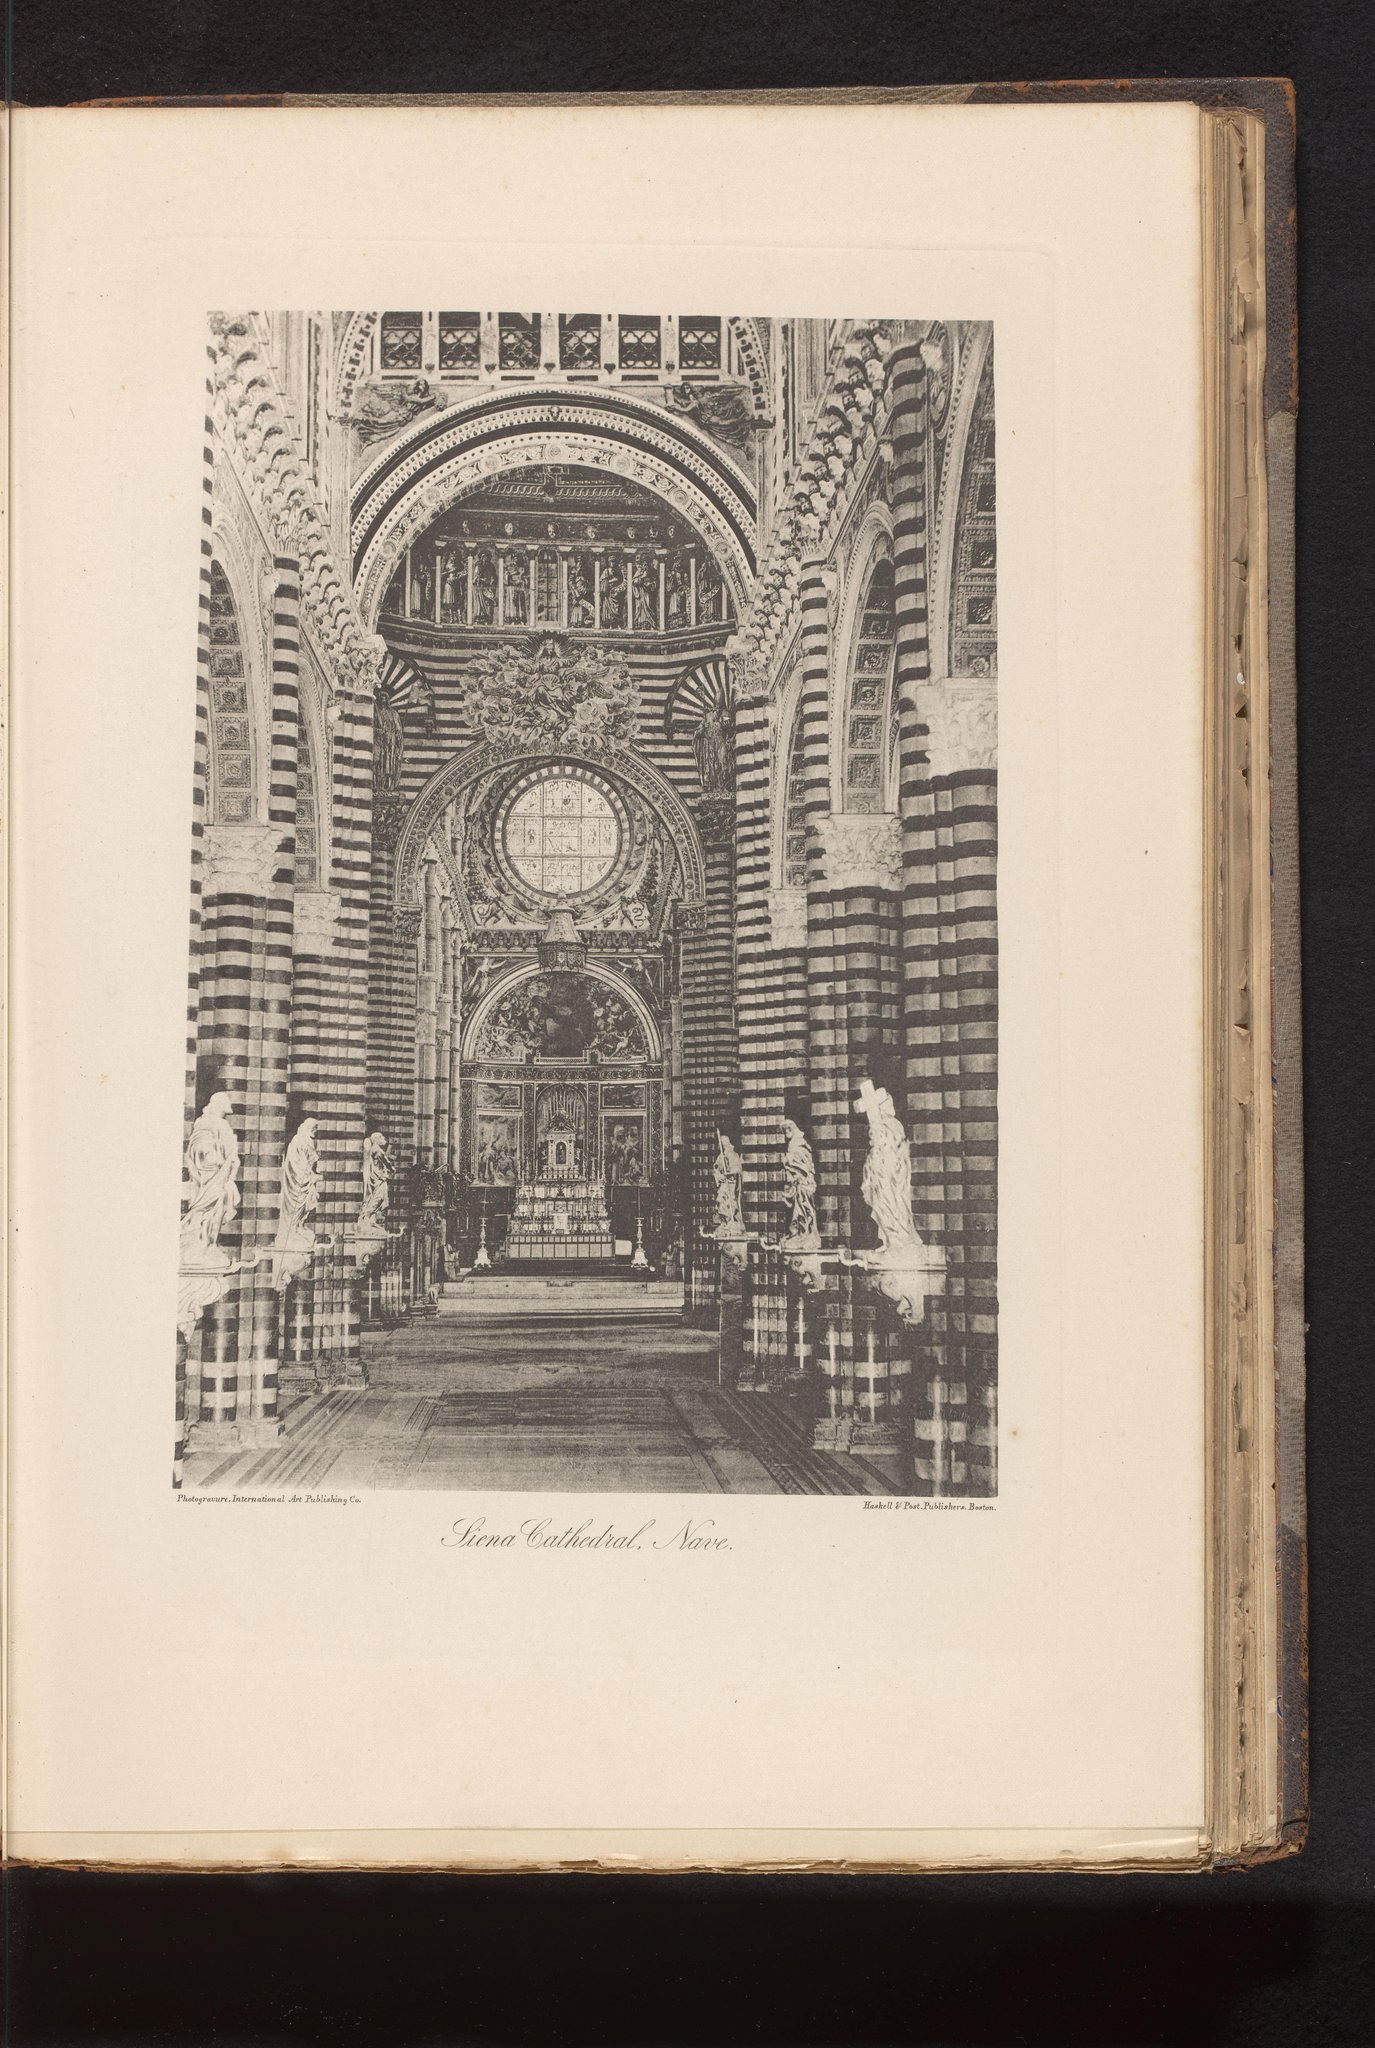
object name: page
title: Interieur van de kathedraal van Siena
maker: Anonymous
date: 1881-1886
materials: paper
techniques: photograph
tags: parts of church interior: nave